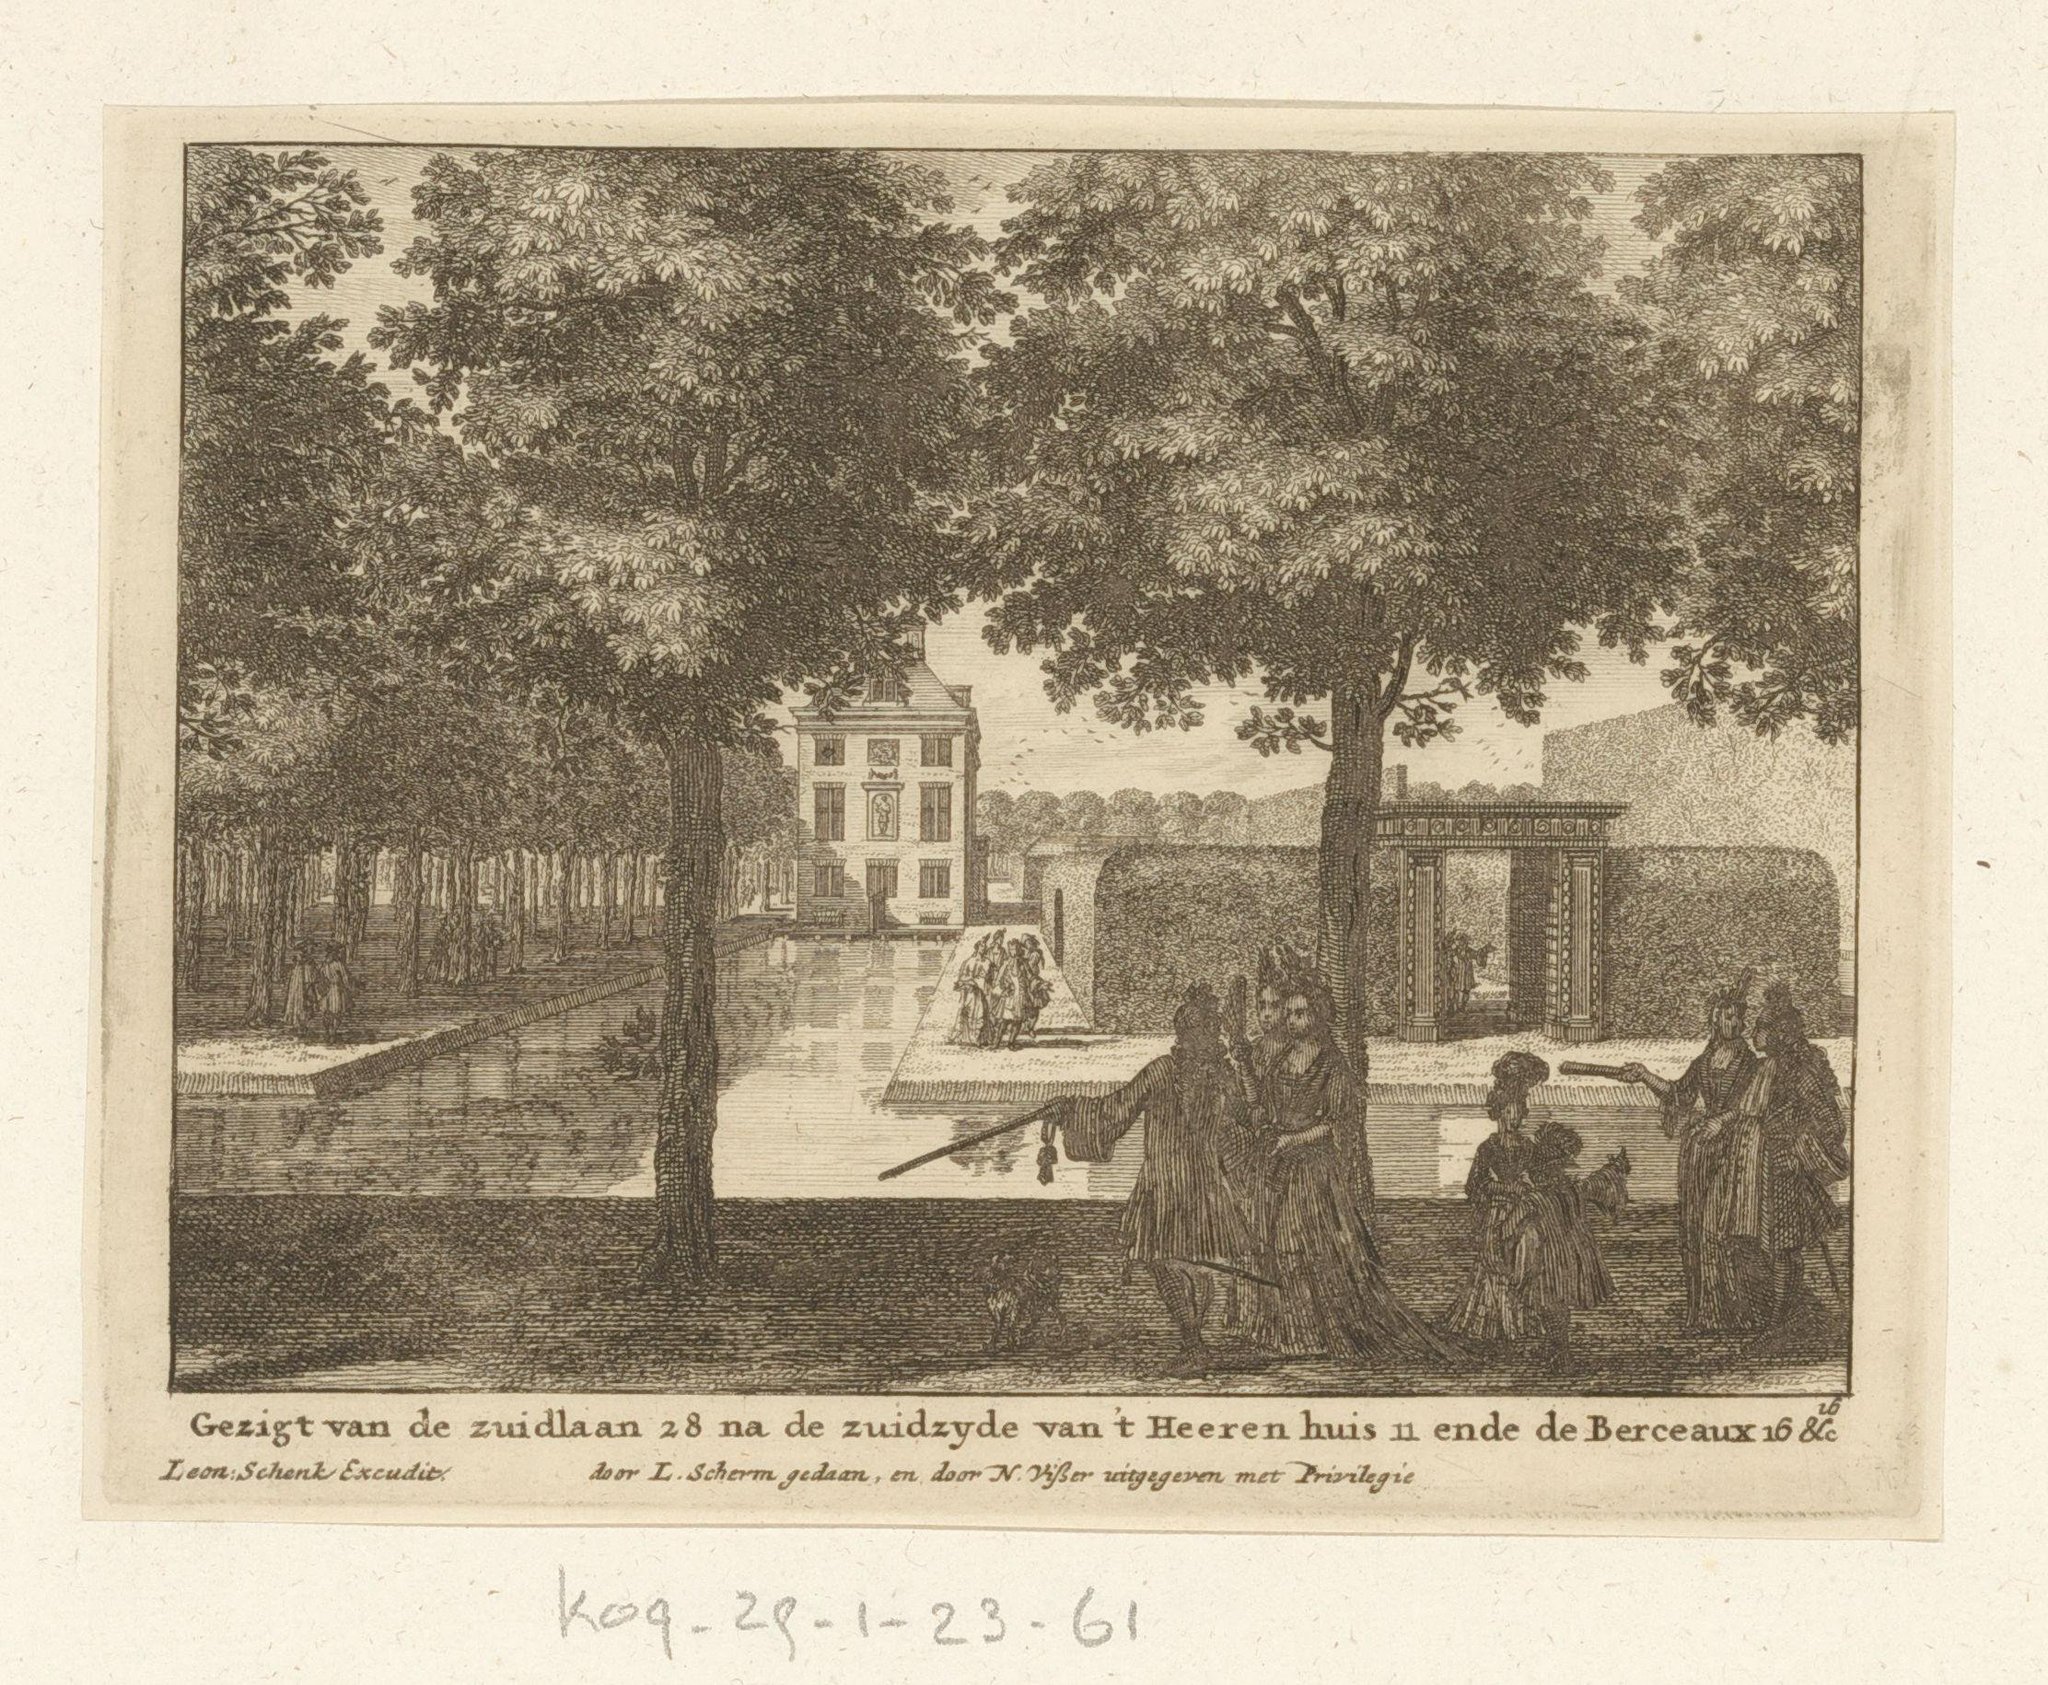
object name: print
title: Zuidlaan op landgoed Clingendael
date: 1706-1767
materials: paper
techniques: engraving, etching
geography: amsterdam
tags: french or architectonic garden; formal garden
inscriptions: stamp, stamp, collector's mark: Lugt 1641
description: Tuin met een gracht aan de zuidzijde van Huis Clingendael te Den Haag. Onder de bomen elegant geklede wandelende dames en heren. Onderwerpsrubrieken binnen de Atlas Zeden en Gewoonten: Zeden en Gewoonten in Engeren Zin, De Woning. Kastelen en buitenplaatsen. Holland.